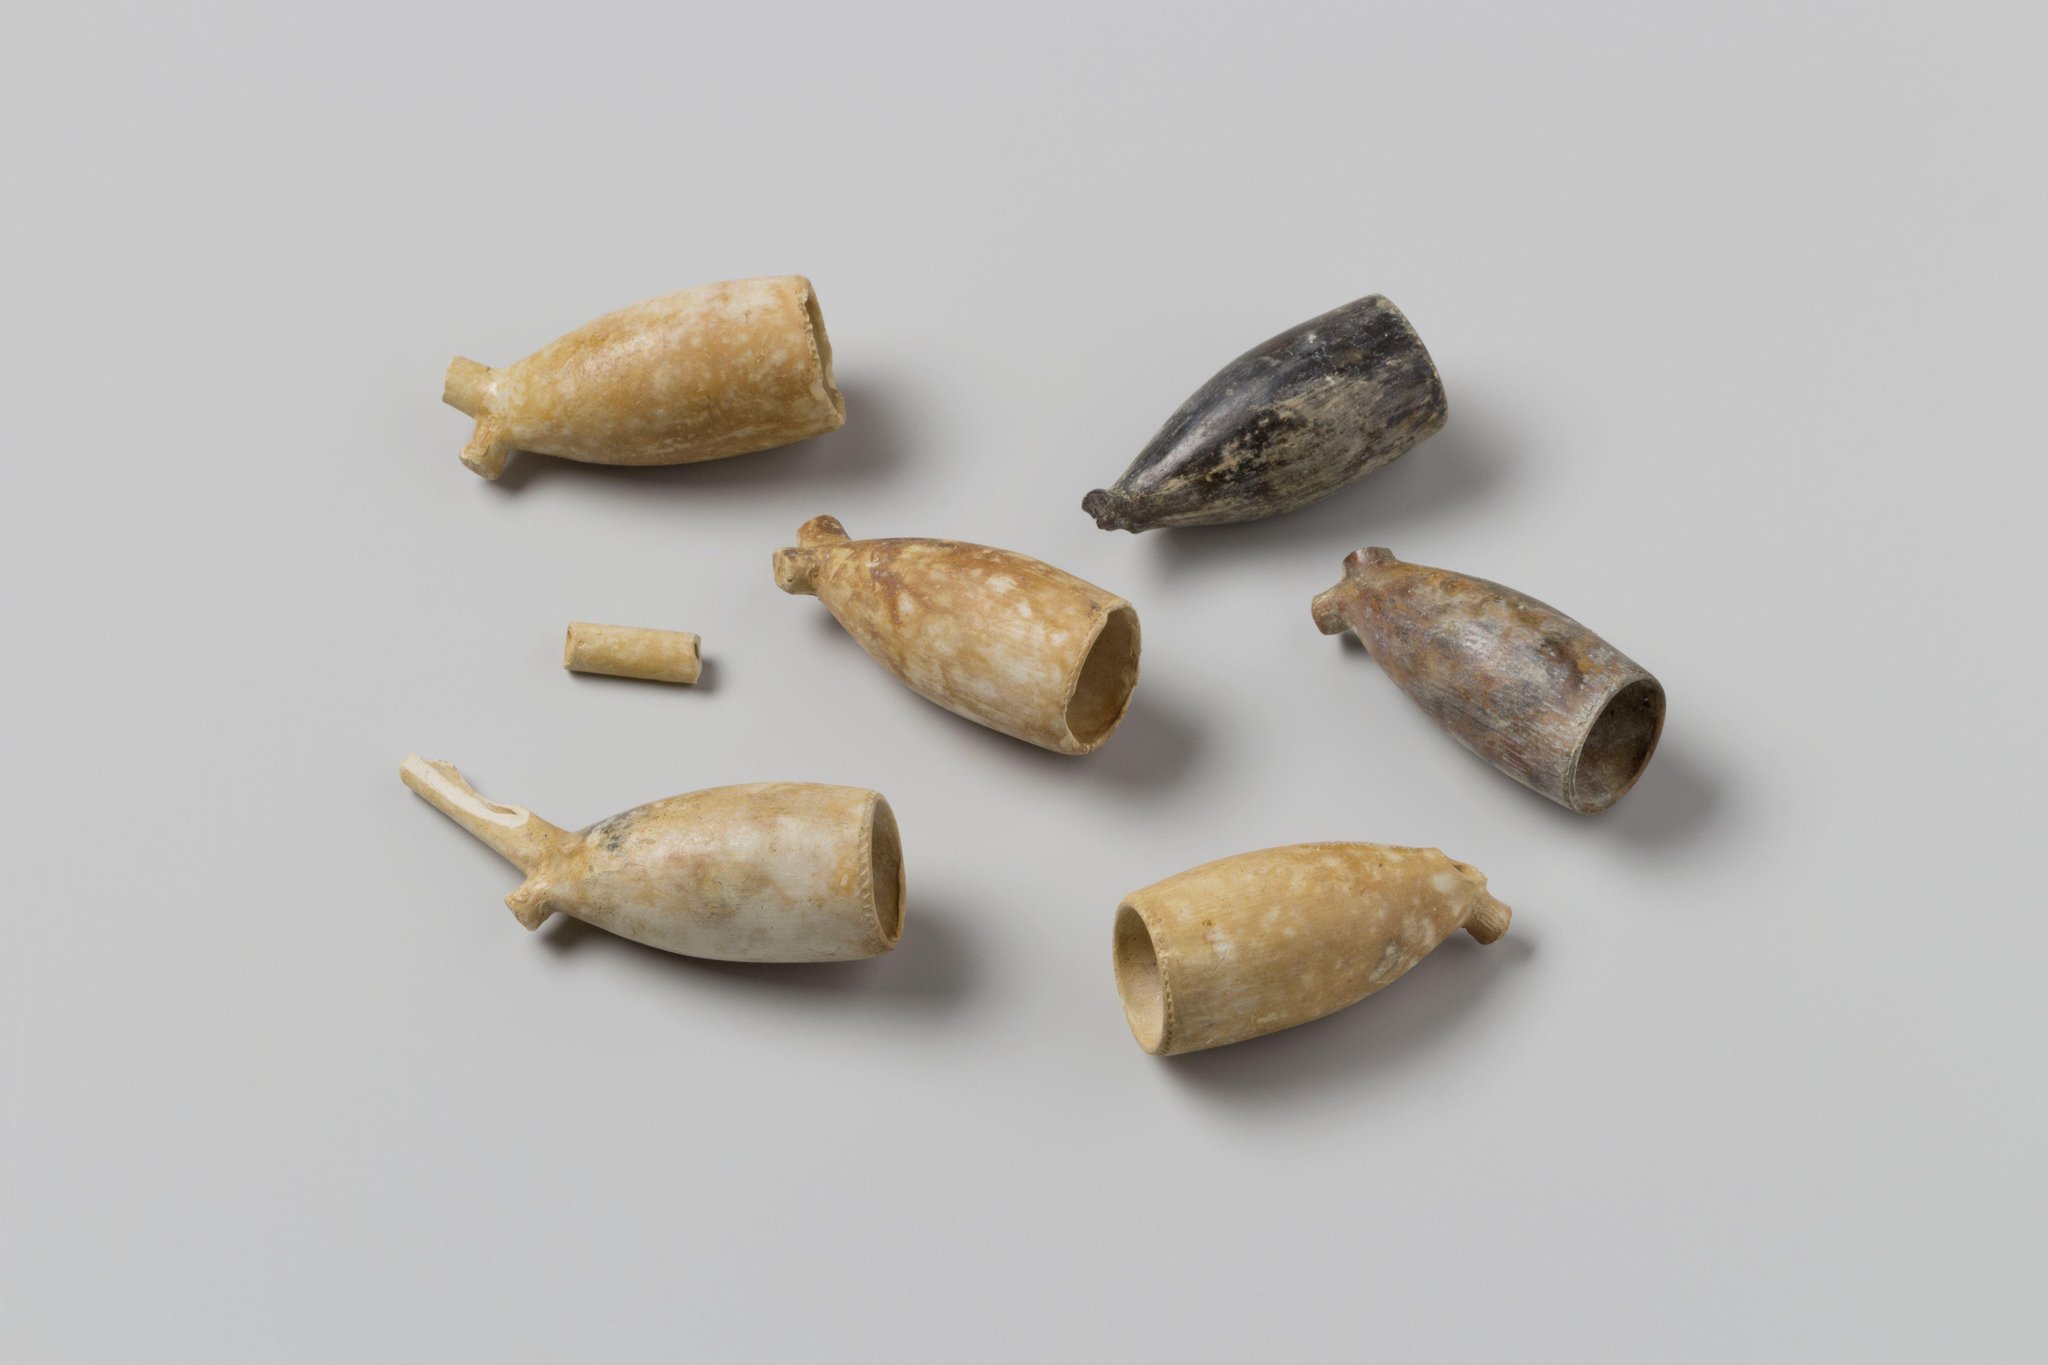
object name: pipe bowl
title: Pijpenkoppen en fragment pijpensteel uit het wrak van de Oost-Indiëvaarder Hollandia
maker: Anonymous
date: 1700-1743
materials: clay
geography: netherlands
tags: verenigde oostindische compagnie, hollandia (schip), annet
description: Pipe, bowl, heelmark: tobacco's brazier; no hsm, 2hsm1,2 2hsm1, 2hsm2.